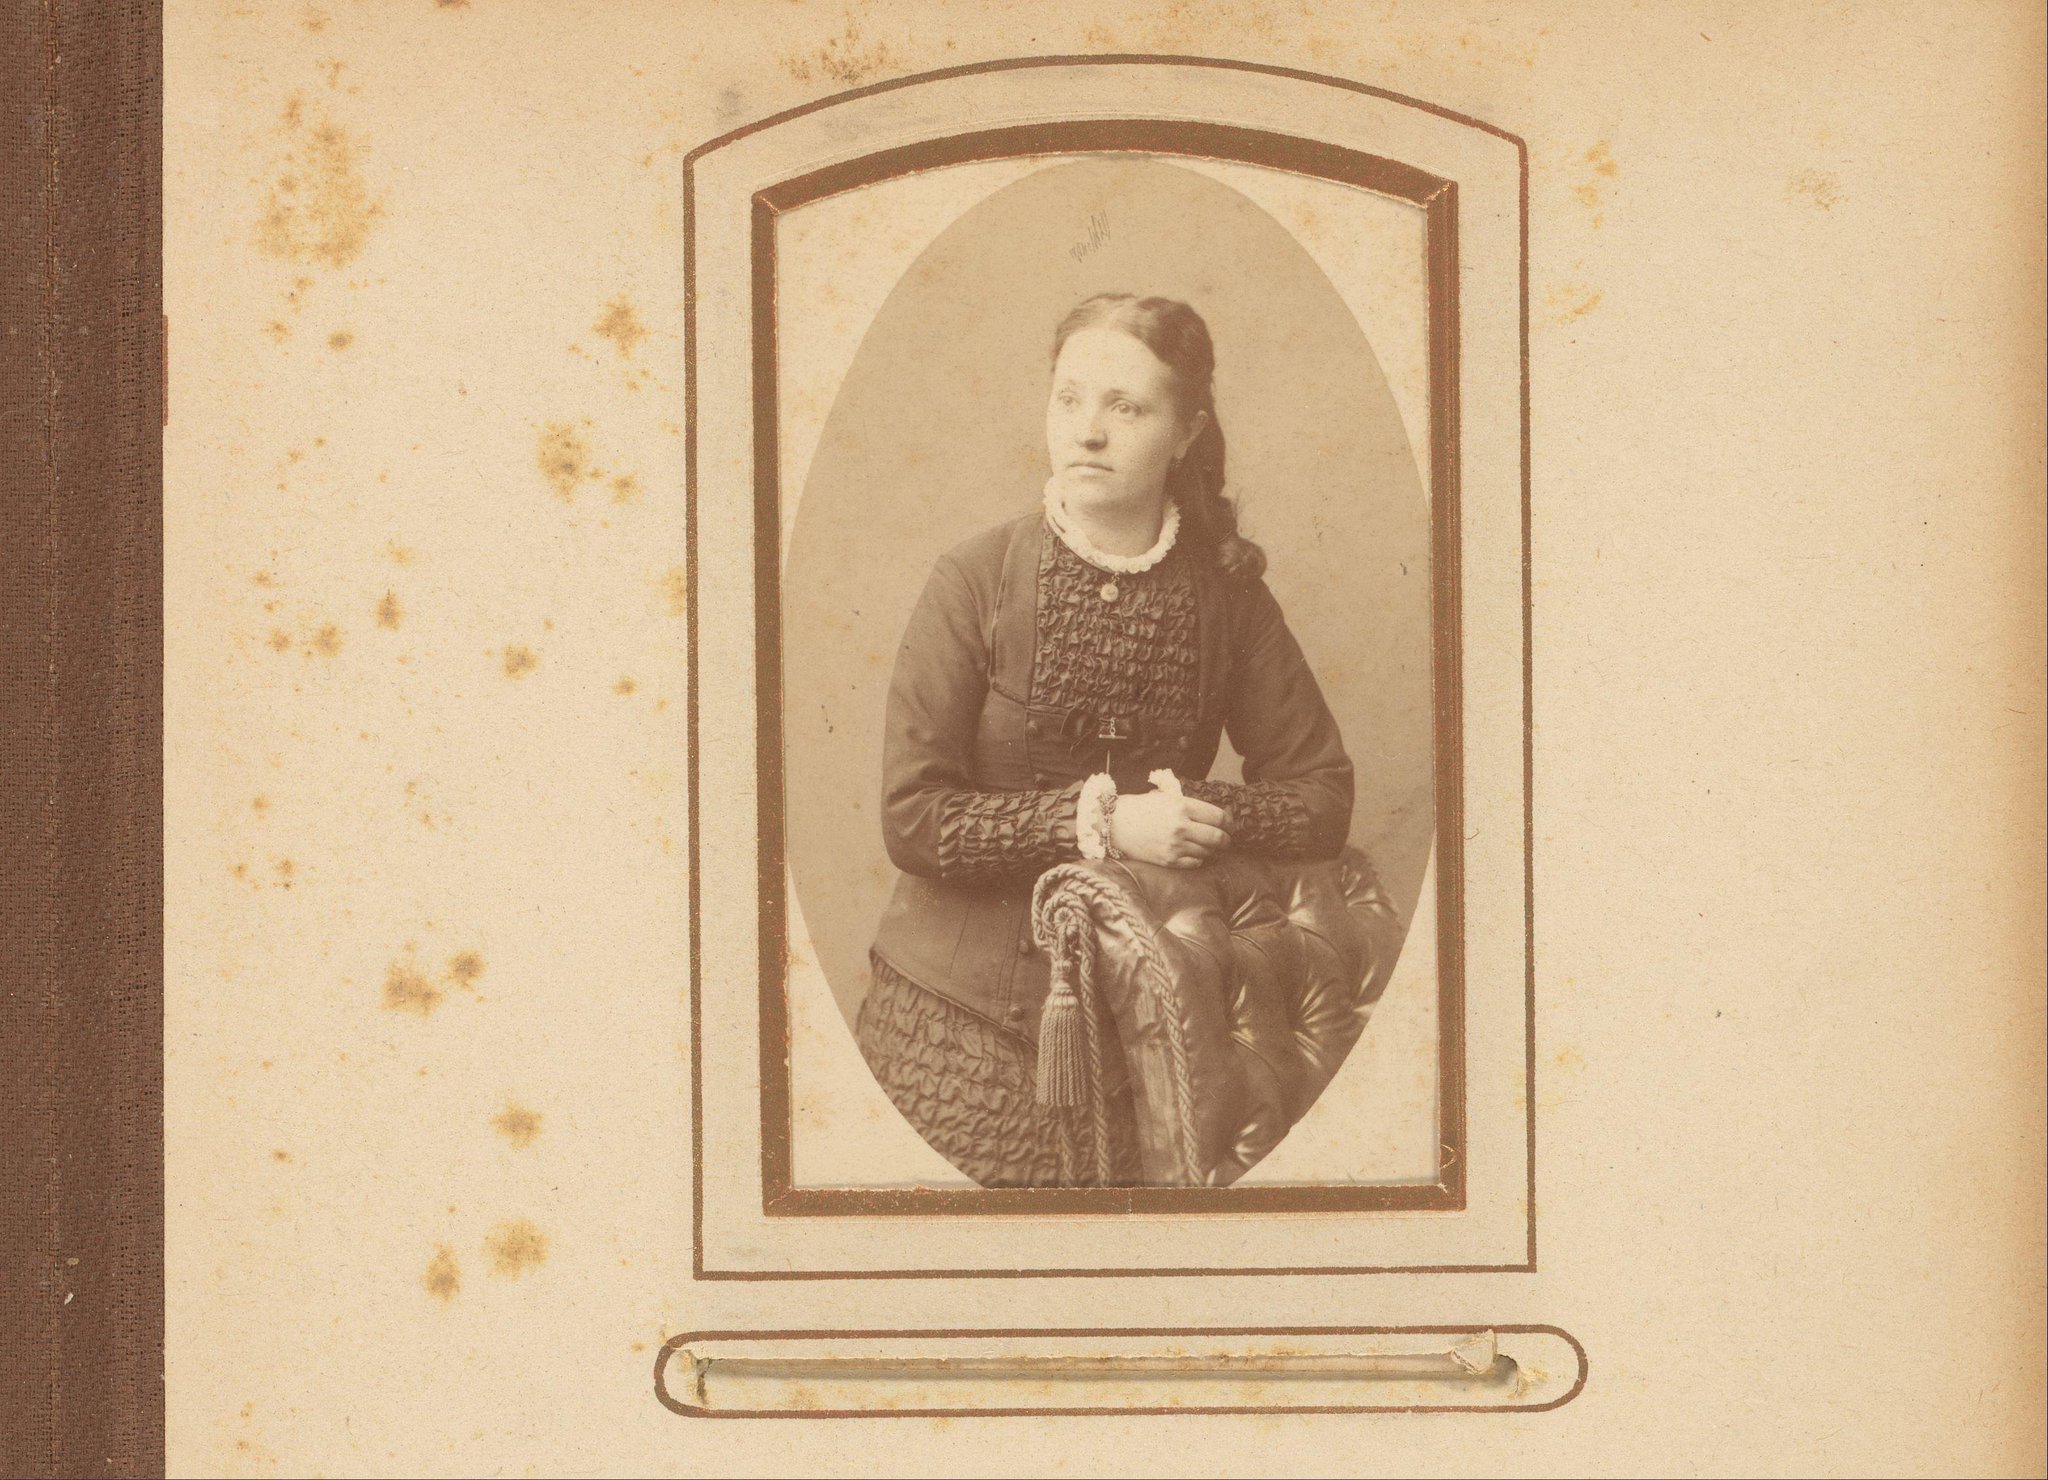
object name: carte de visite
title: Portret van een jonge vrouw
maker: hendrik jonker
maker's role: fotograaf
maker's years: 1846-1932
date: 1882-1914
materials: cardboard, photographic support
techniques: albumen print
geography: leiden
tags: adolescent, young woman, maiden, historical persons - bb - woman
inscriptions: inscription: ‘Photographisch Atelier van/ H. Jonker/ Apothekersdijk No.7/ Leiden’